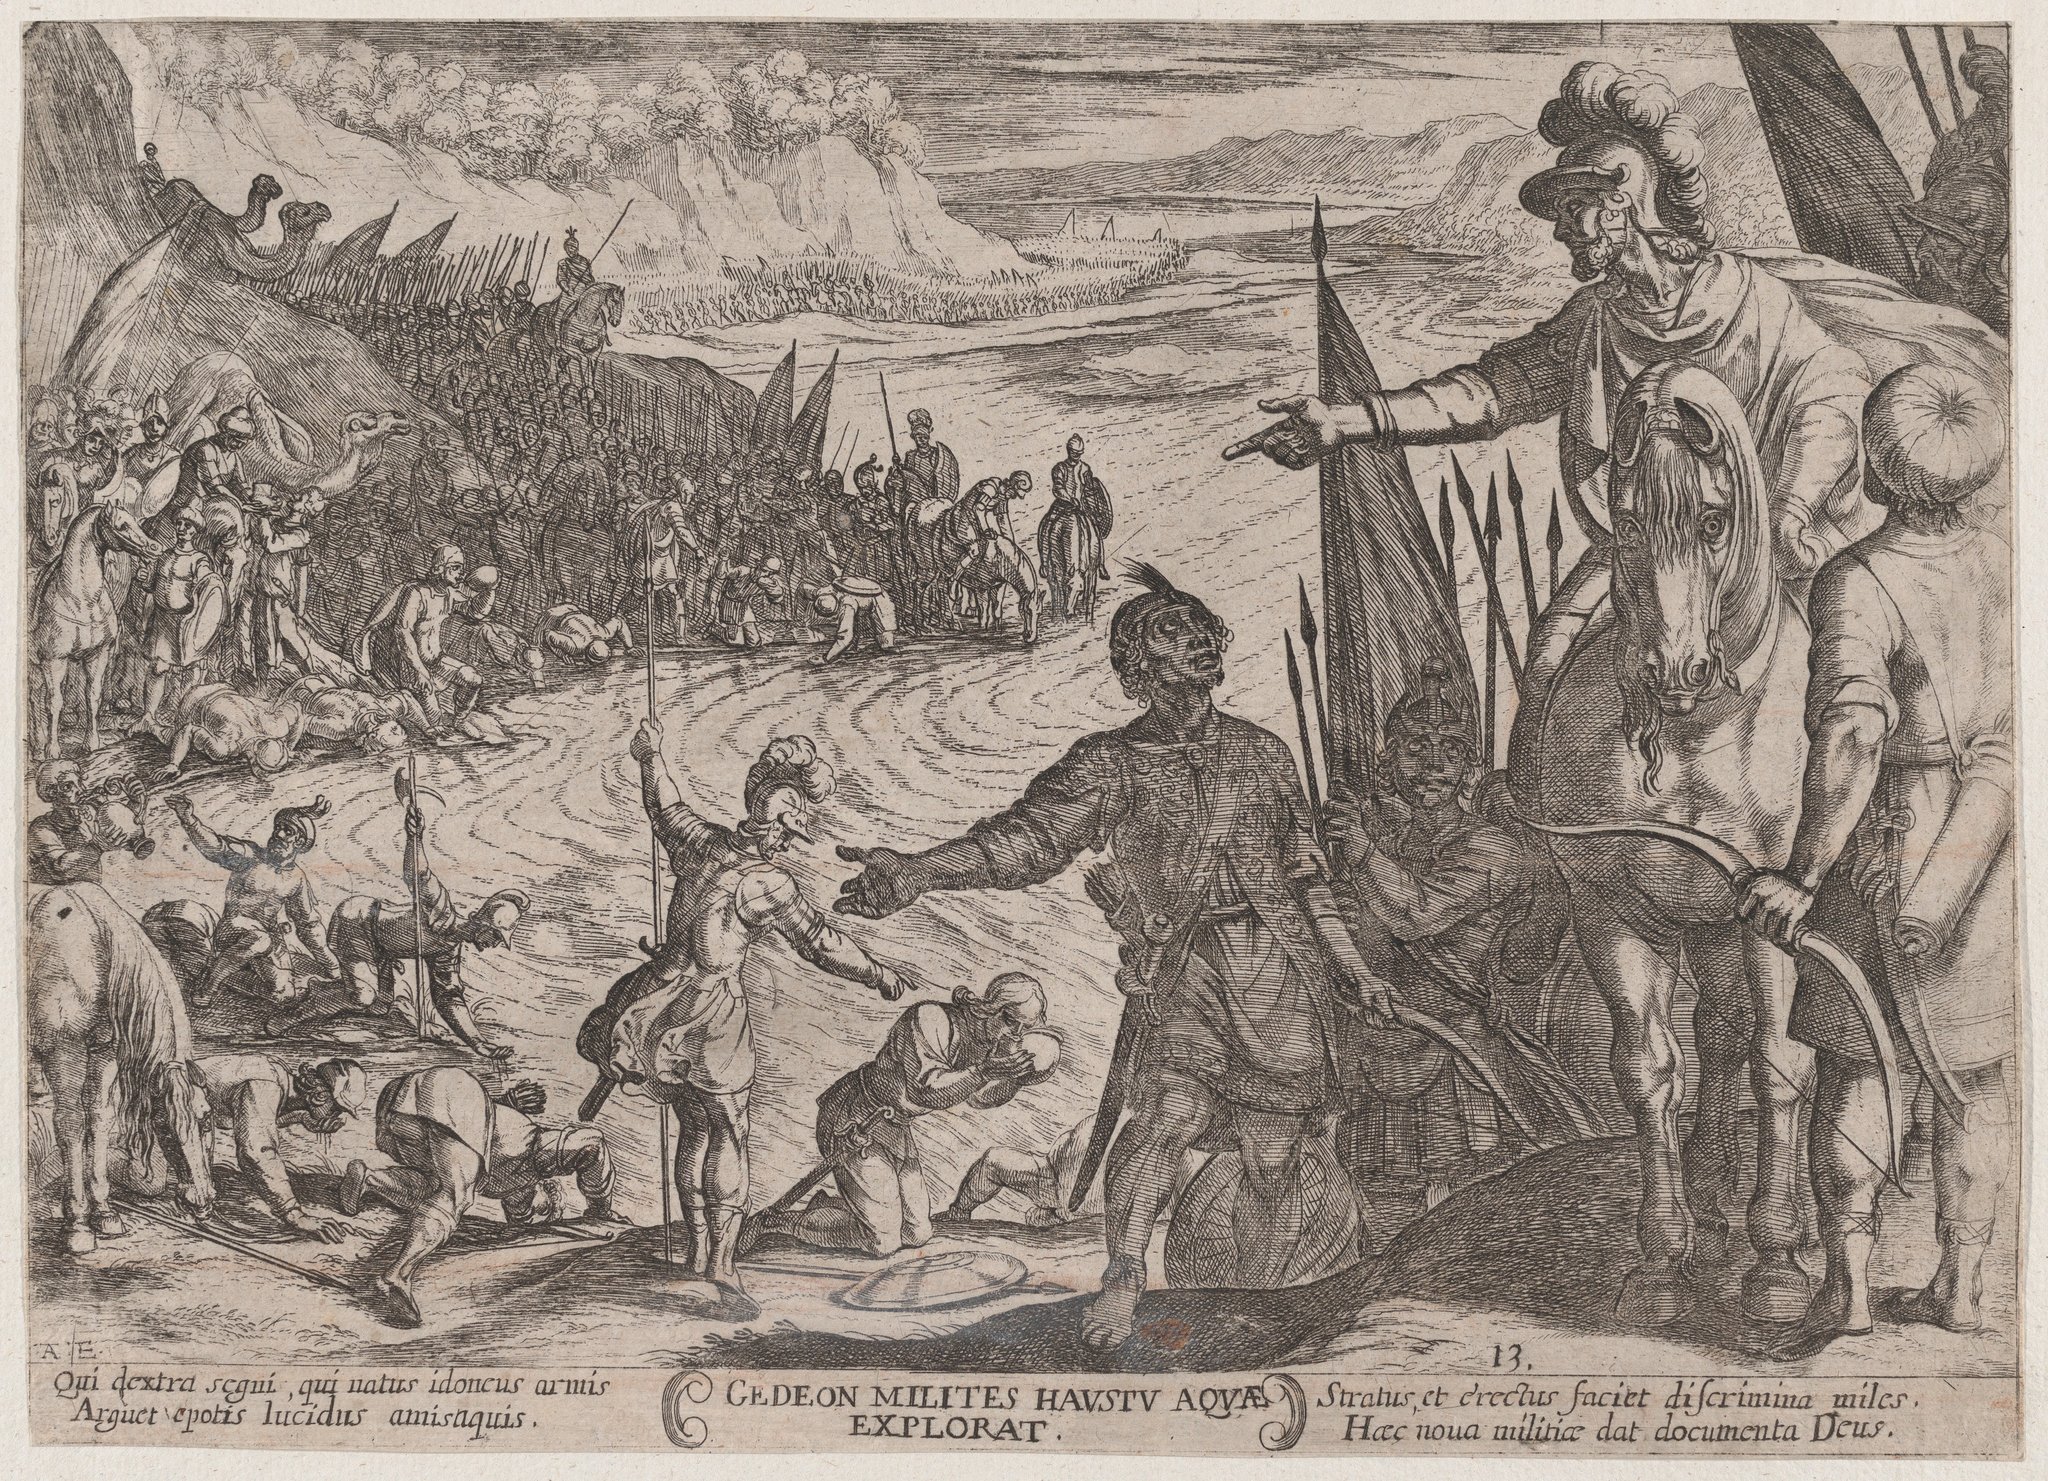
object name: print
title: Plate 13: Gideon Choosing his Soldiers, from "The Battles of the Old Testament"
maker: antonio tempesta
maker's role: artist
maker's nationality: italian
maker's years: 1555-1630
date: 1590-1610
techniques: etching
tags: battles,soldiers,men,horses